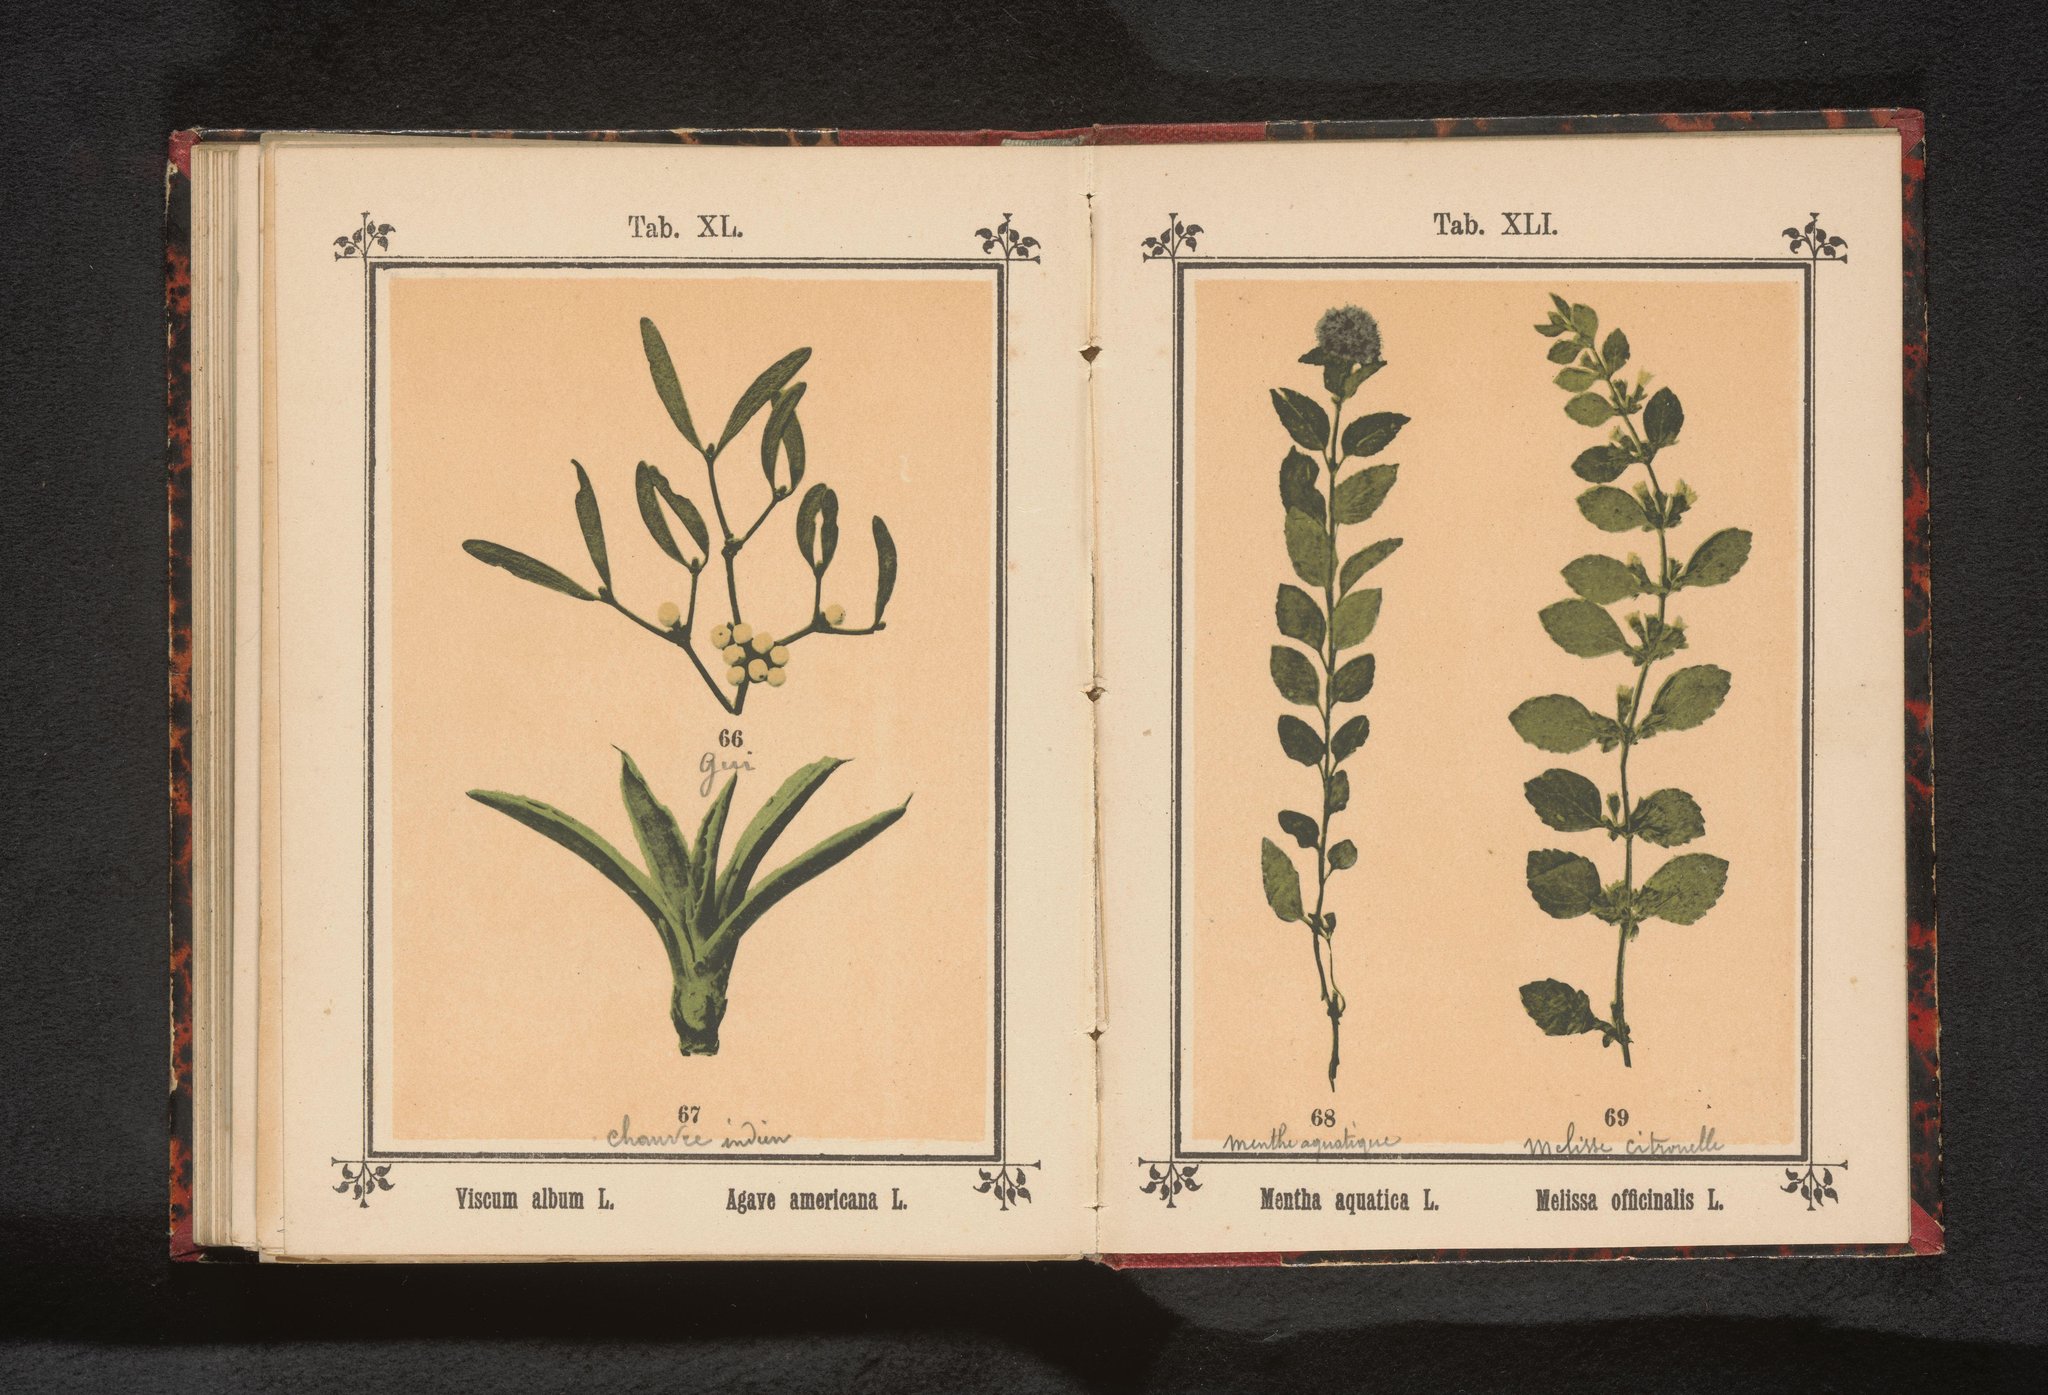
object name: page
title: Viscum album L. Agave americana L.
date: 1884-1894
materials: paper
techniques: photograph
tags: plants and herbs, plants and herbs: aloe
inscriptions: inscription: ‘gui chauvée indien’, number: ‘Tab. XL.’